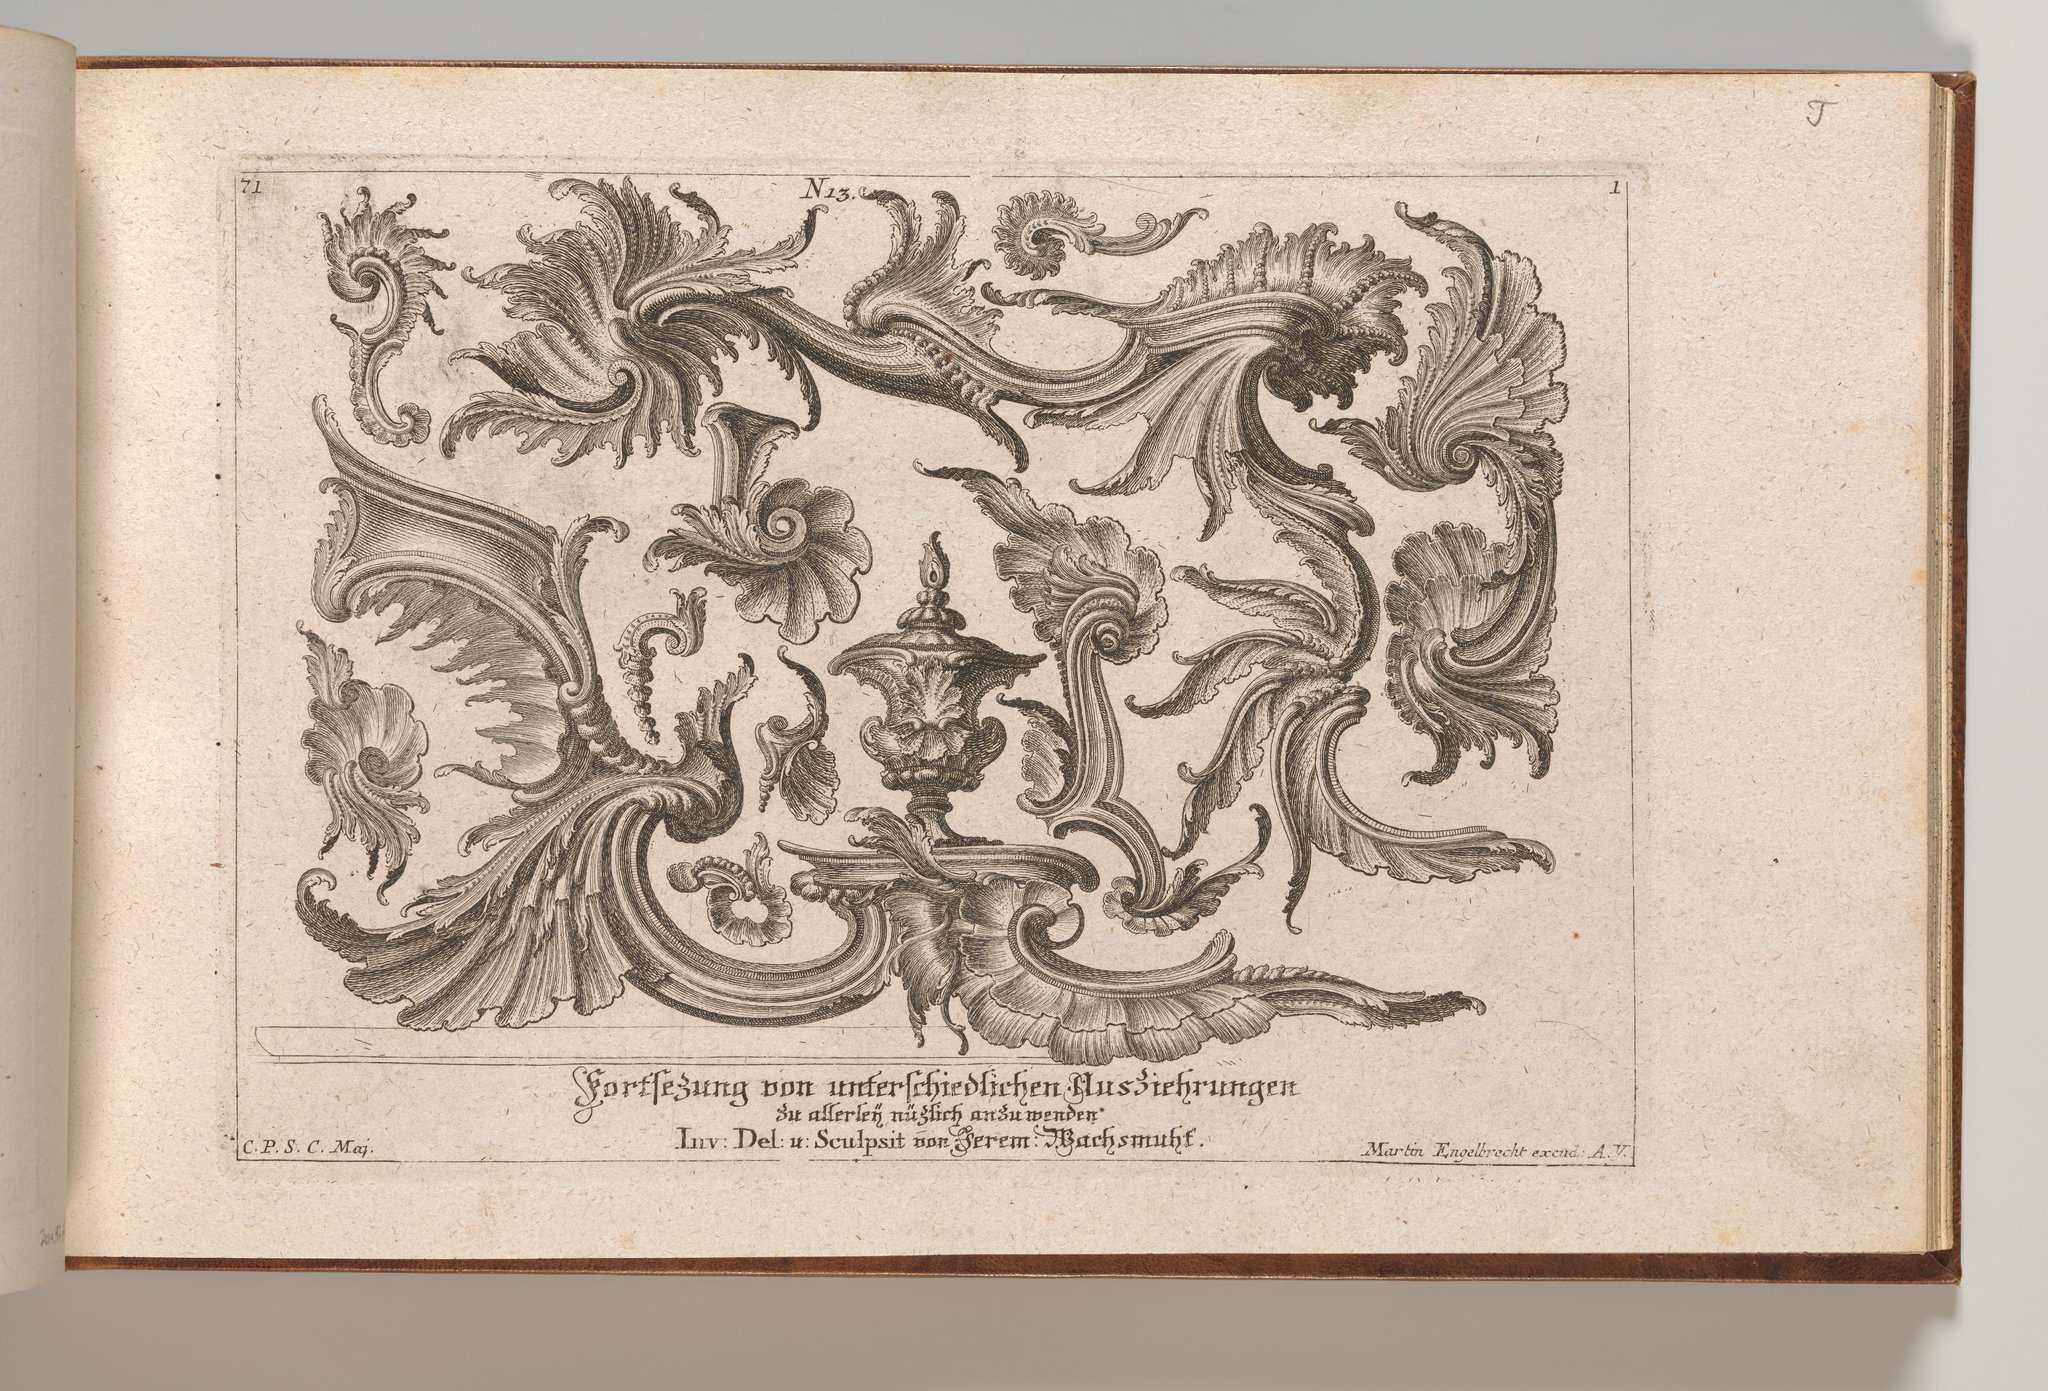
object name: album print ornament architecture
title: Various Designs for Rocaille Ornaments, Plate 1 from: 'Fortsezung von unterschielichen Auszierungen zu allerleij nüzlich anzuwenden'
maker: jeremias wachsmuth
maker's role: artist and engraver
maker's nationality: german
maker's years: 1712-1771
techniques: etching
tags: ornament